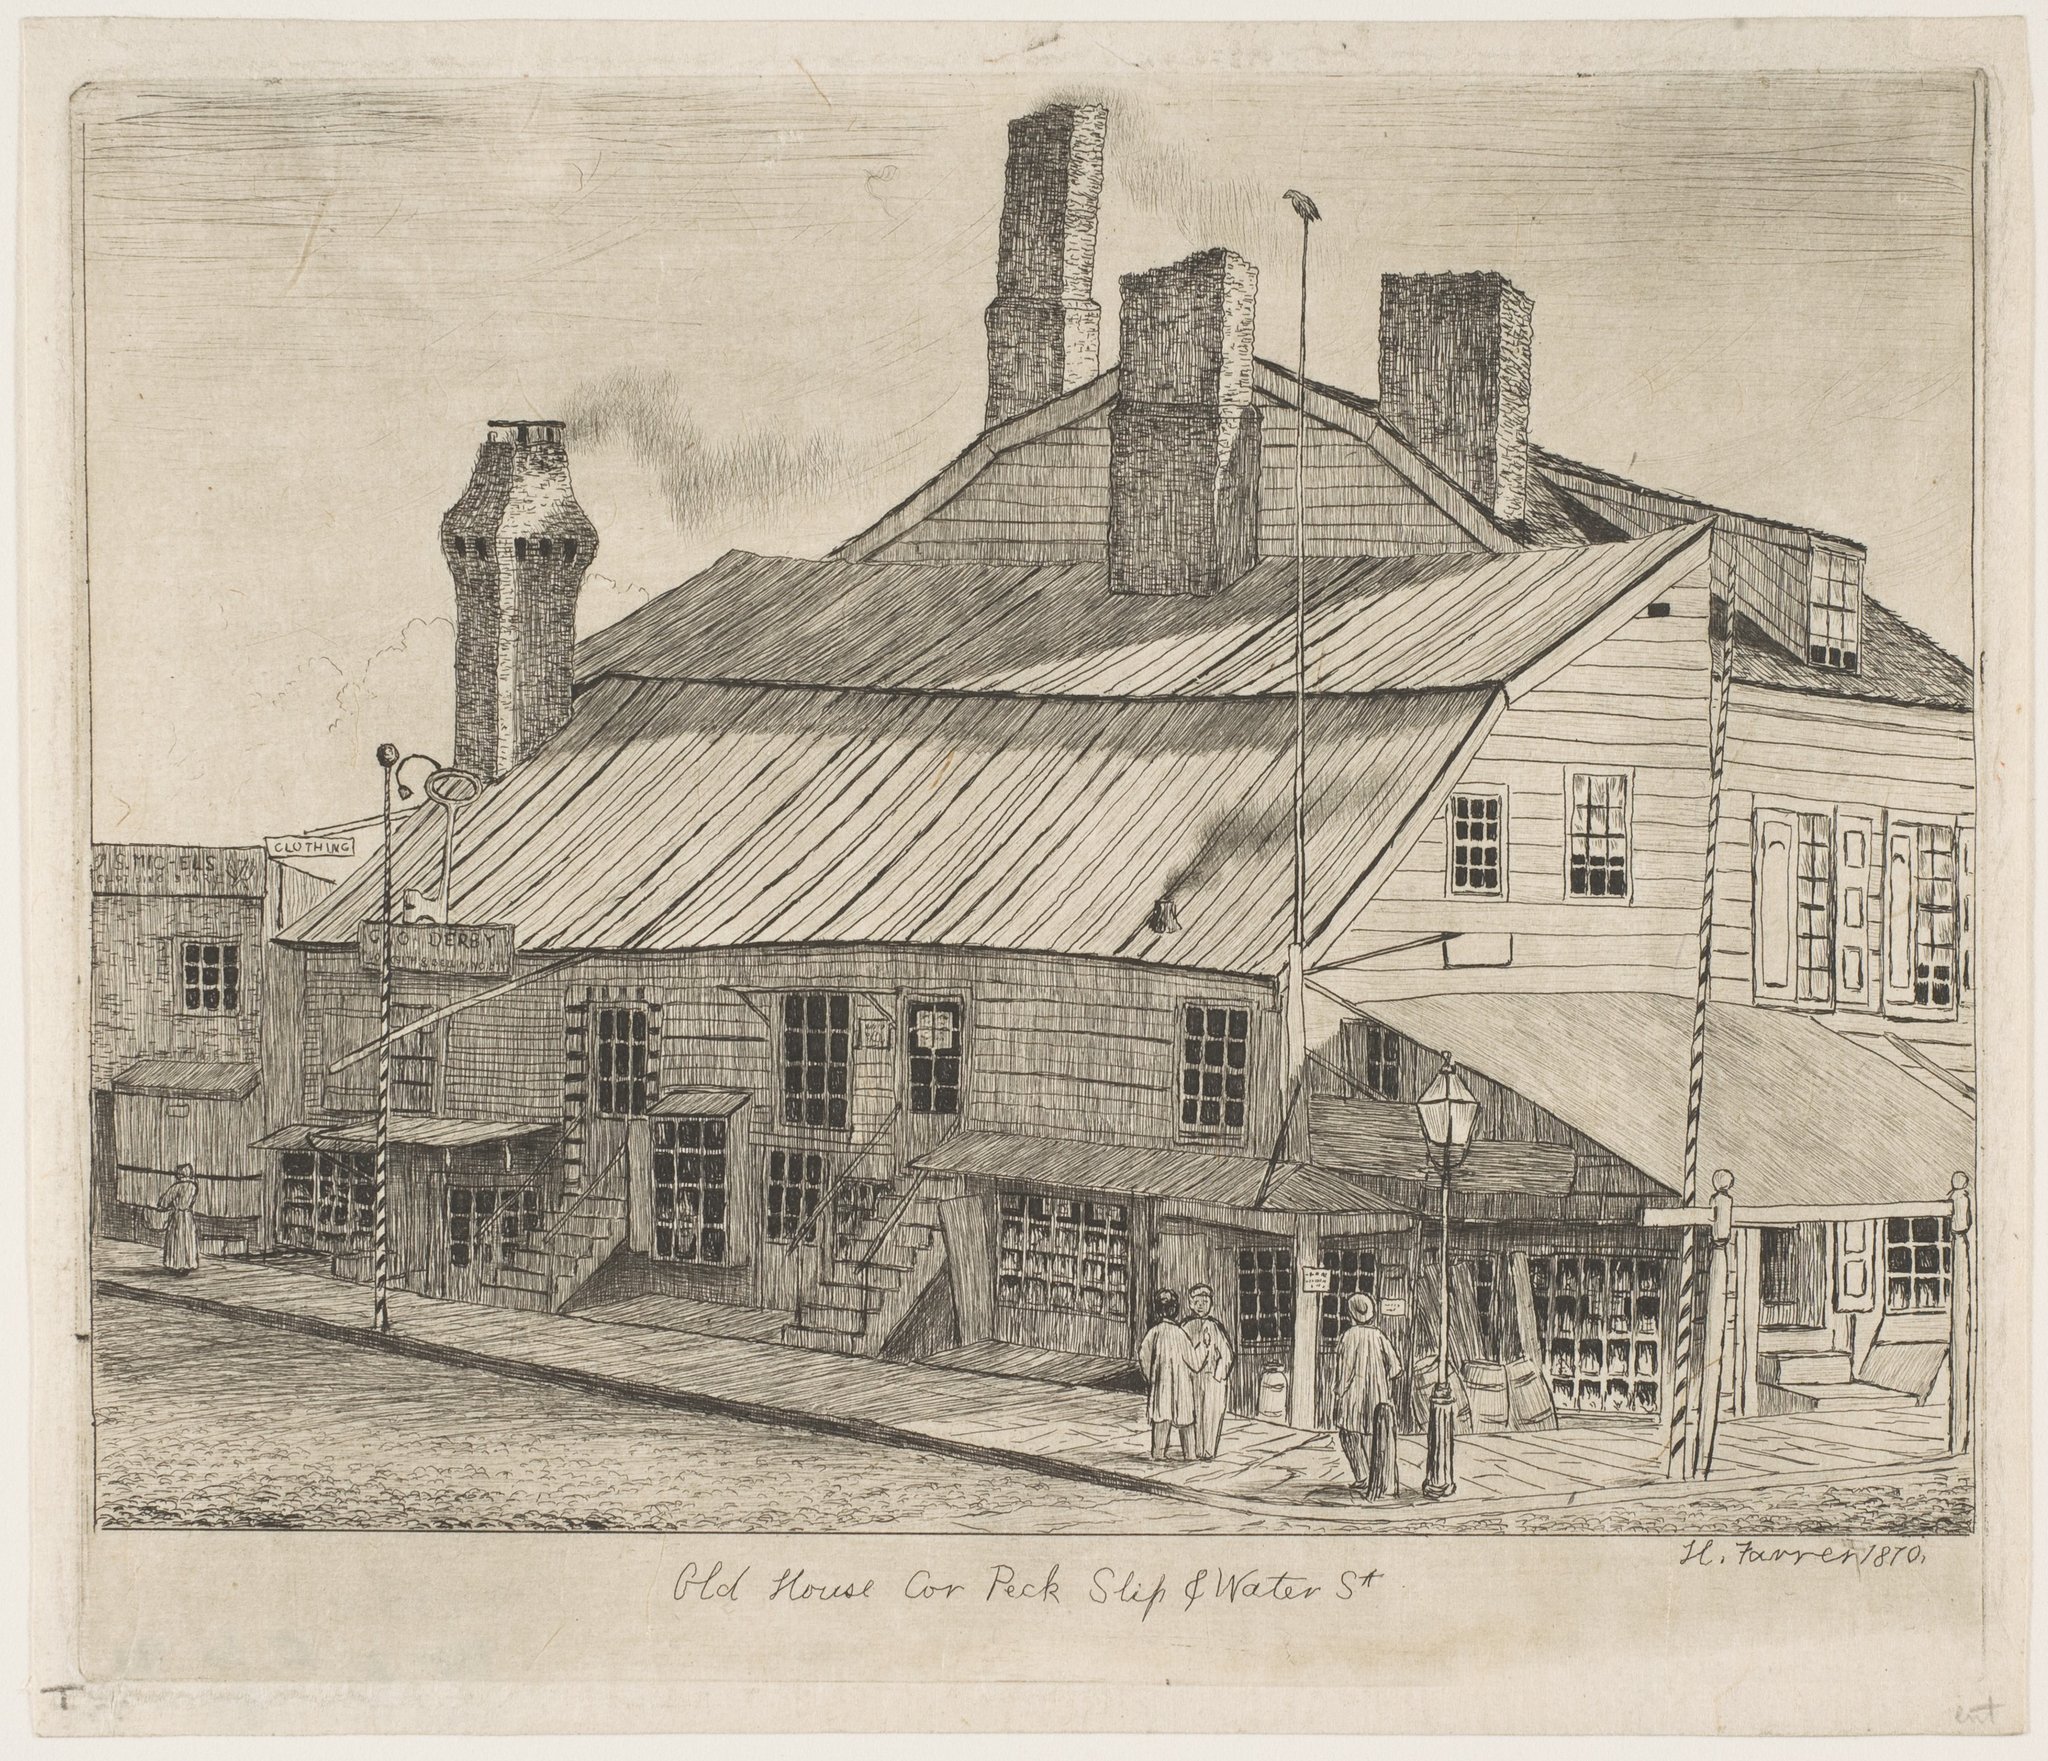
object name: print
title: Old House, Corner of Peck Slip and Water Street, from "Scenes of Old New York"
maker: henry farrer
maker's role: artist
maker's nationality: american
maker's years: 1844-1903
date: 1870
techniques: etching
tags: houses,new york city